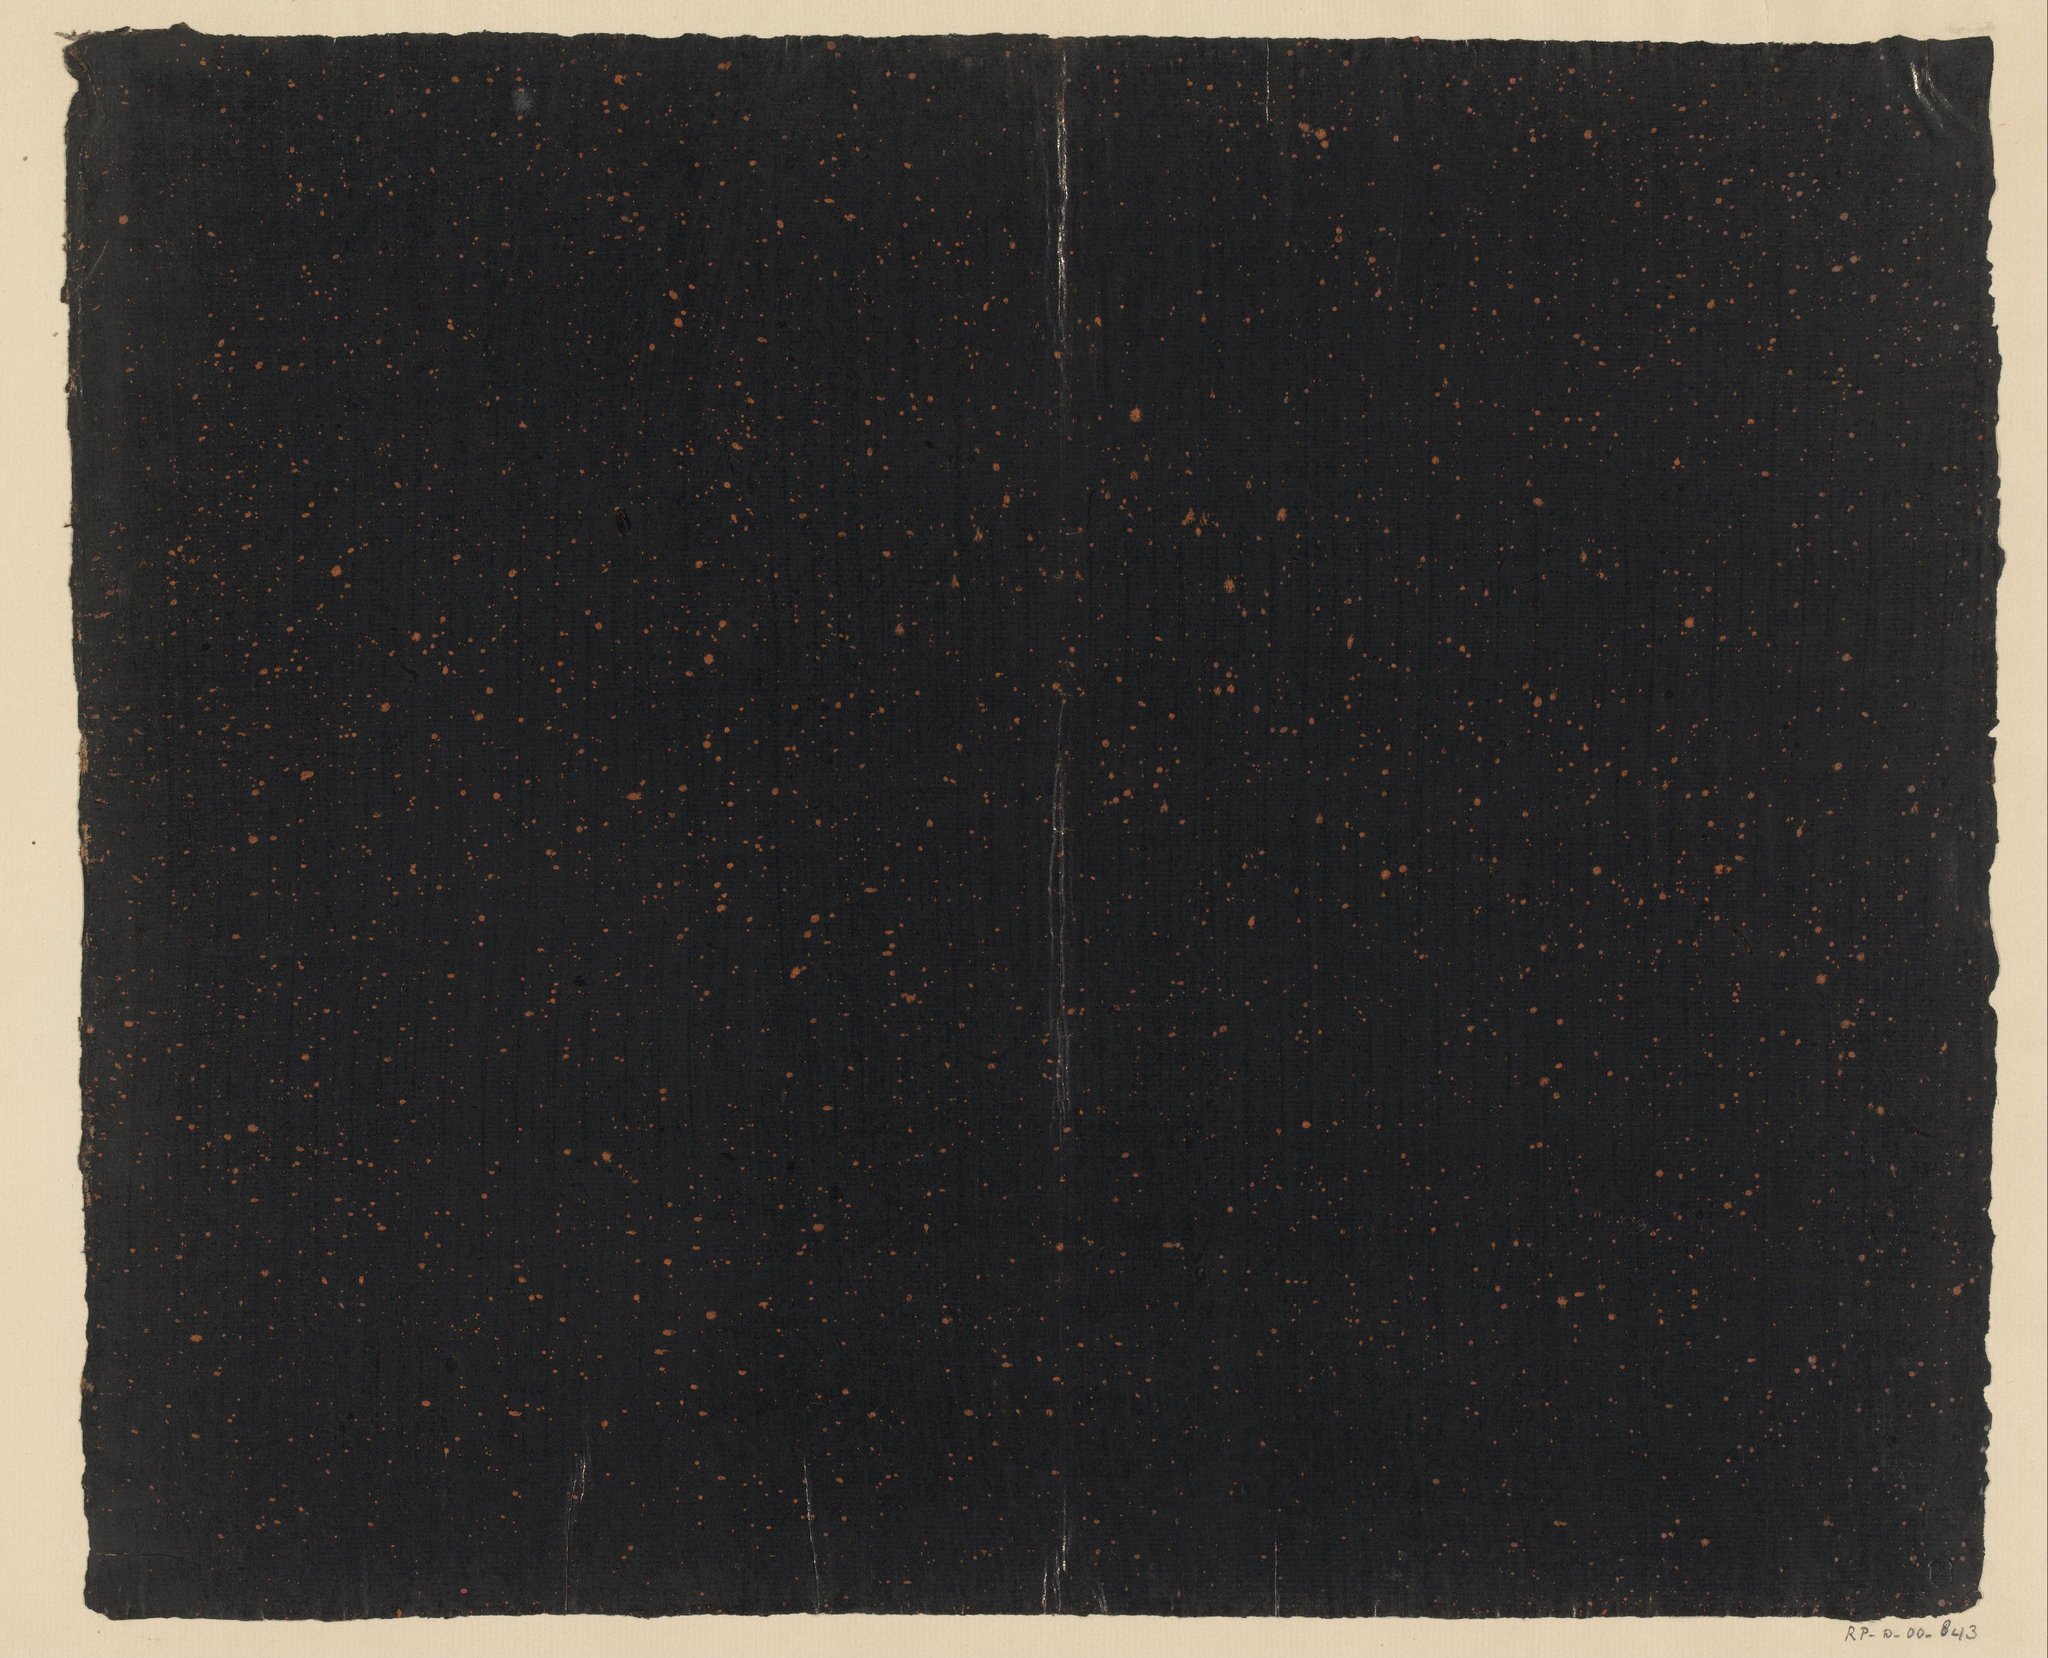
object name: sprinkled paper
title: Oranje gespikkeld zwart papier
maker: Anonymous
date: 1750-1900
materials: lacquer, paper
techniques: splatter marble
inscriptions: collector's mark: Lugt 2760